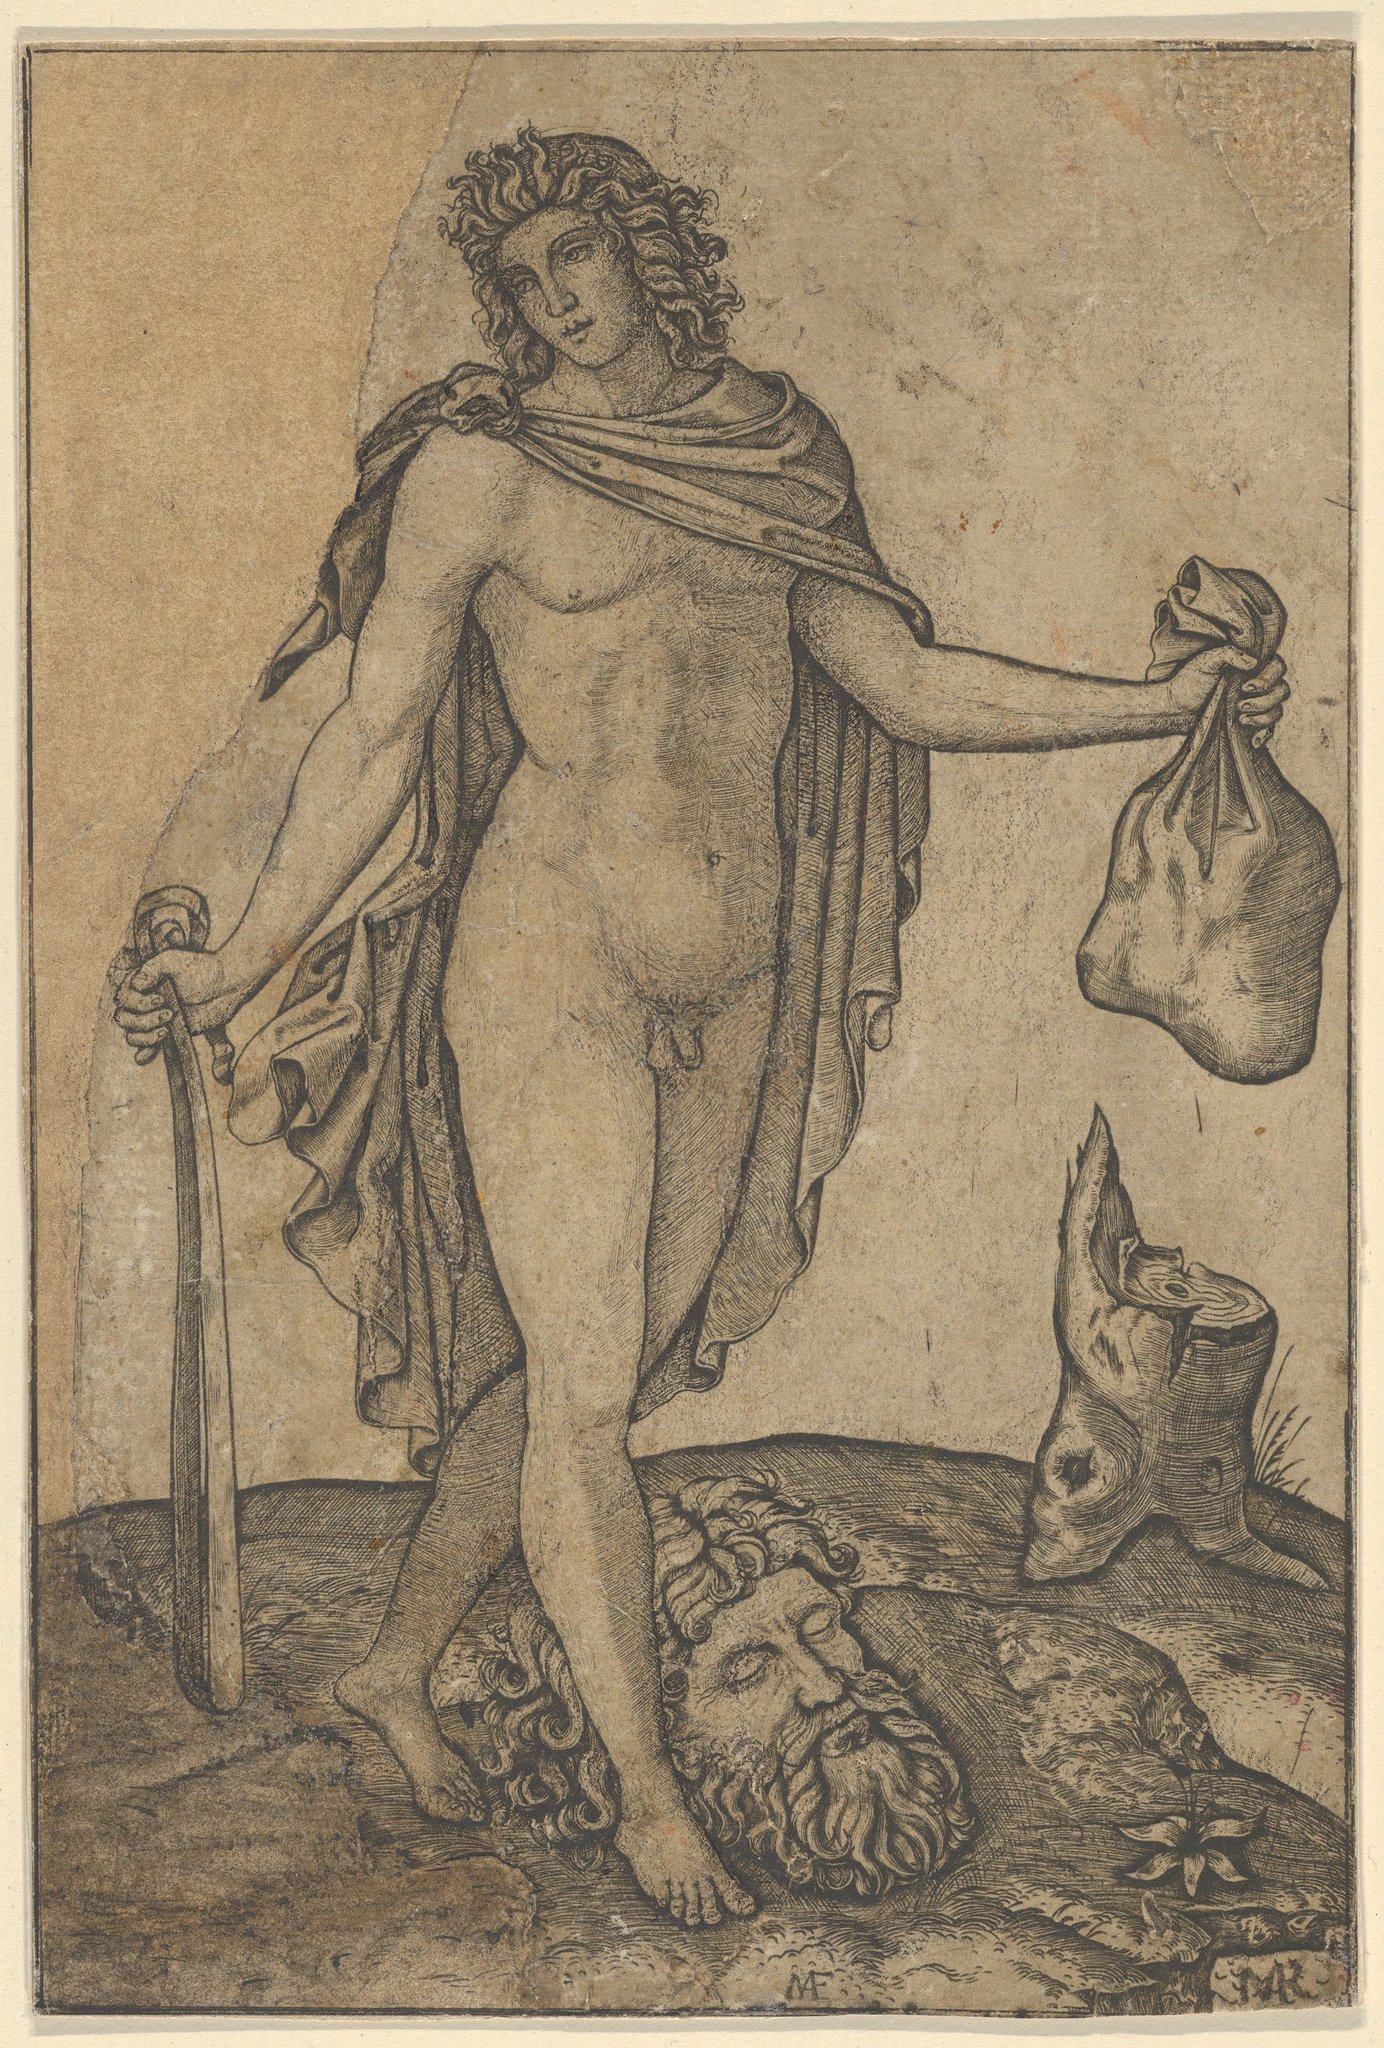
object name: print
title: David standing, sword in lowered right hand, sack in the left, the head of Goliath on the ground beneath him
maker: marcantonio raimondi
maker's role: artist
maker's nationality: italian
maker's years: 1475-1534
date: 1506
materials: ink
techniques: cutting, engraving, pen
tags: swords,hands,heads,david